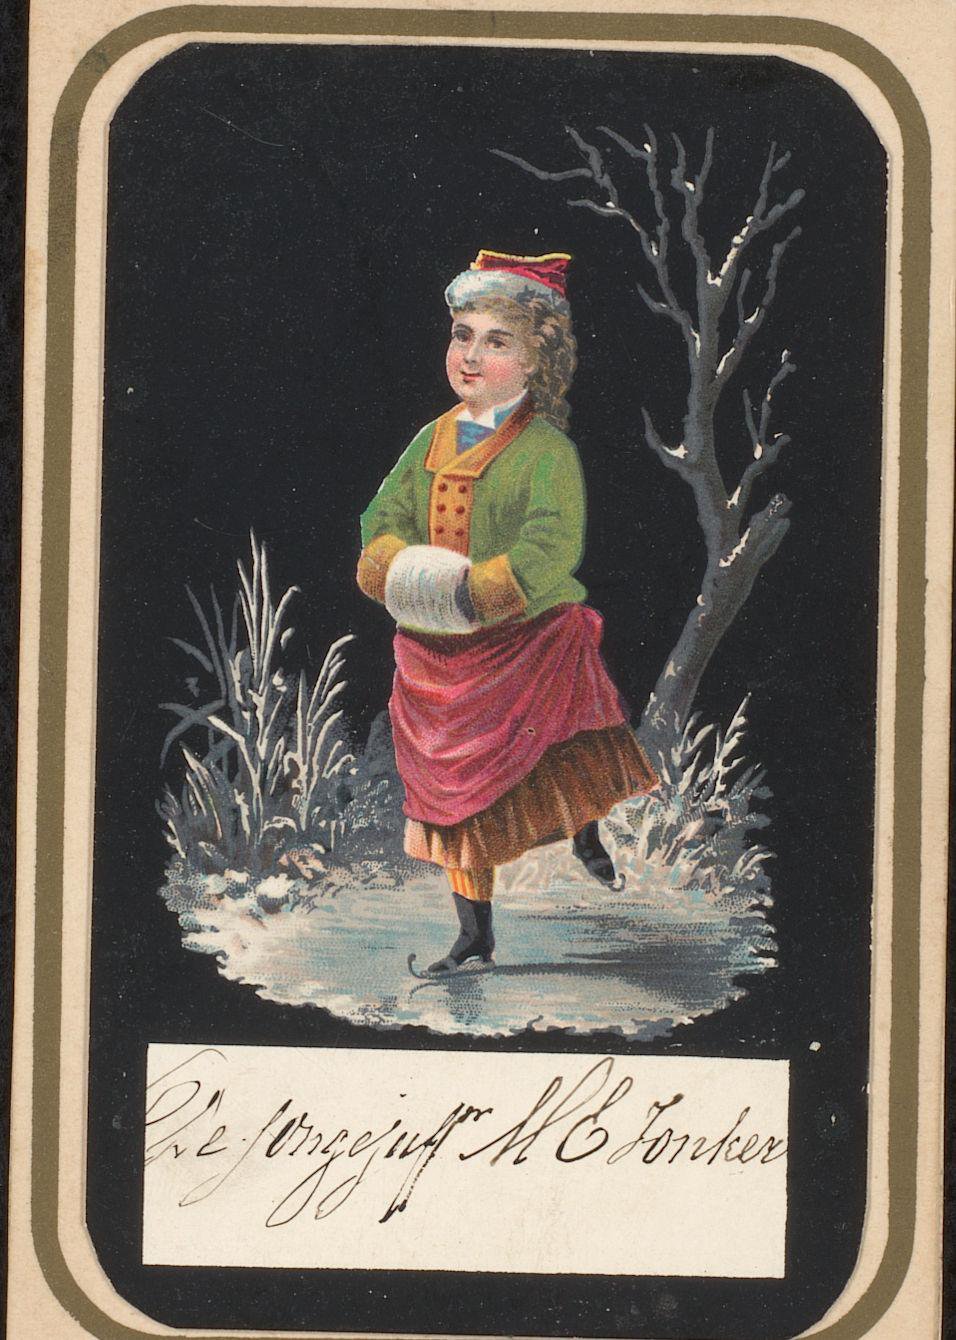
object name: menu, menukaart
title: Menu voor het diner ter ere van het gouden huwelijksjubileum van Lucas Jonker en Maria Engelina van Zijp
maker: Anonymous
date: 1878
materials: paper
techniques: chromolithography, printing block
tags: skates (winter sports), golden anniversary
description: Op de voorzijde een wintertafereel met schaatsende vrouw. Daaronder de naam van de genodigde: 'De jongejuffr. M.E. Jonker'. Binnenin het menu en een decoratie van een vaas of mand met bloemen en fruit. Op de achterzijde details over het diner en het jubileum, gevierd op 27 juli 1878.